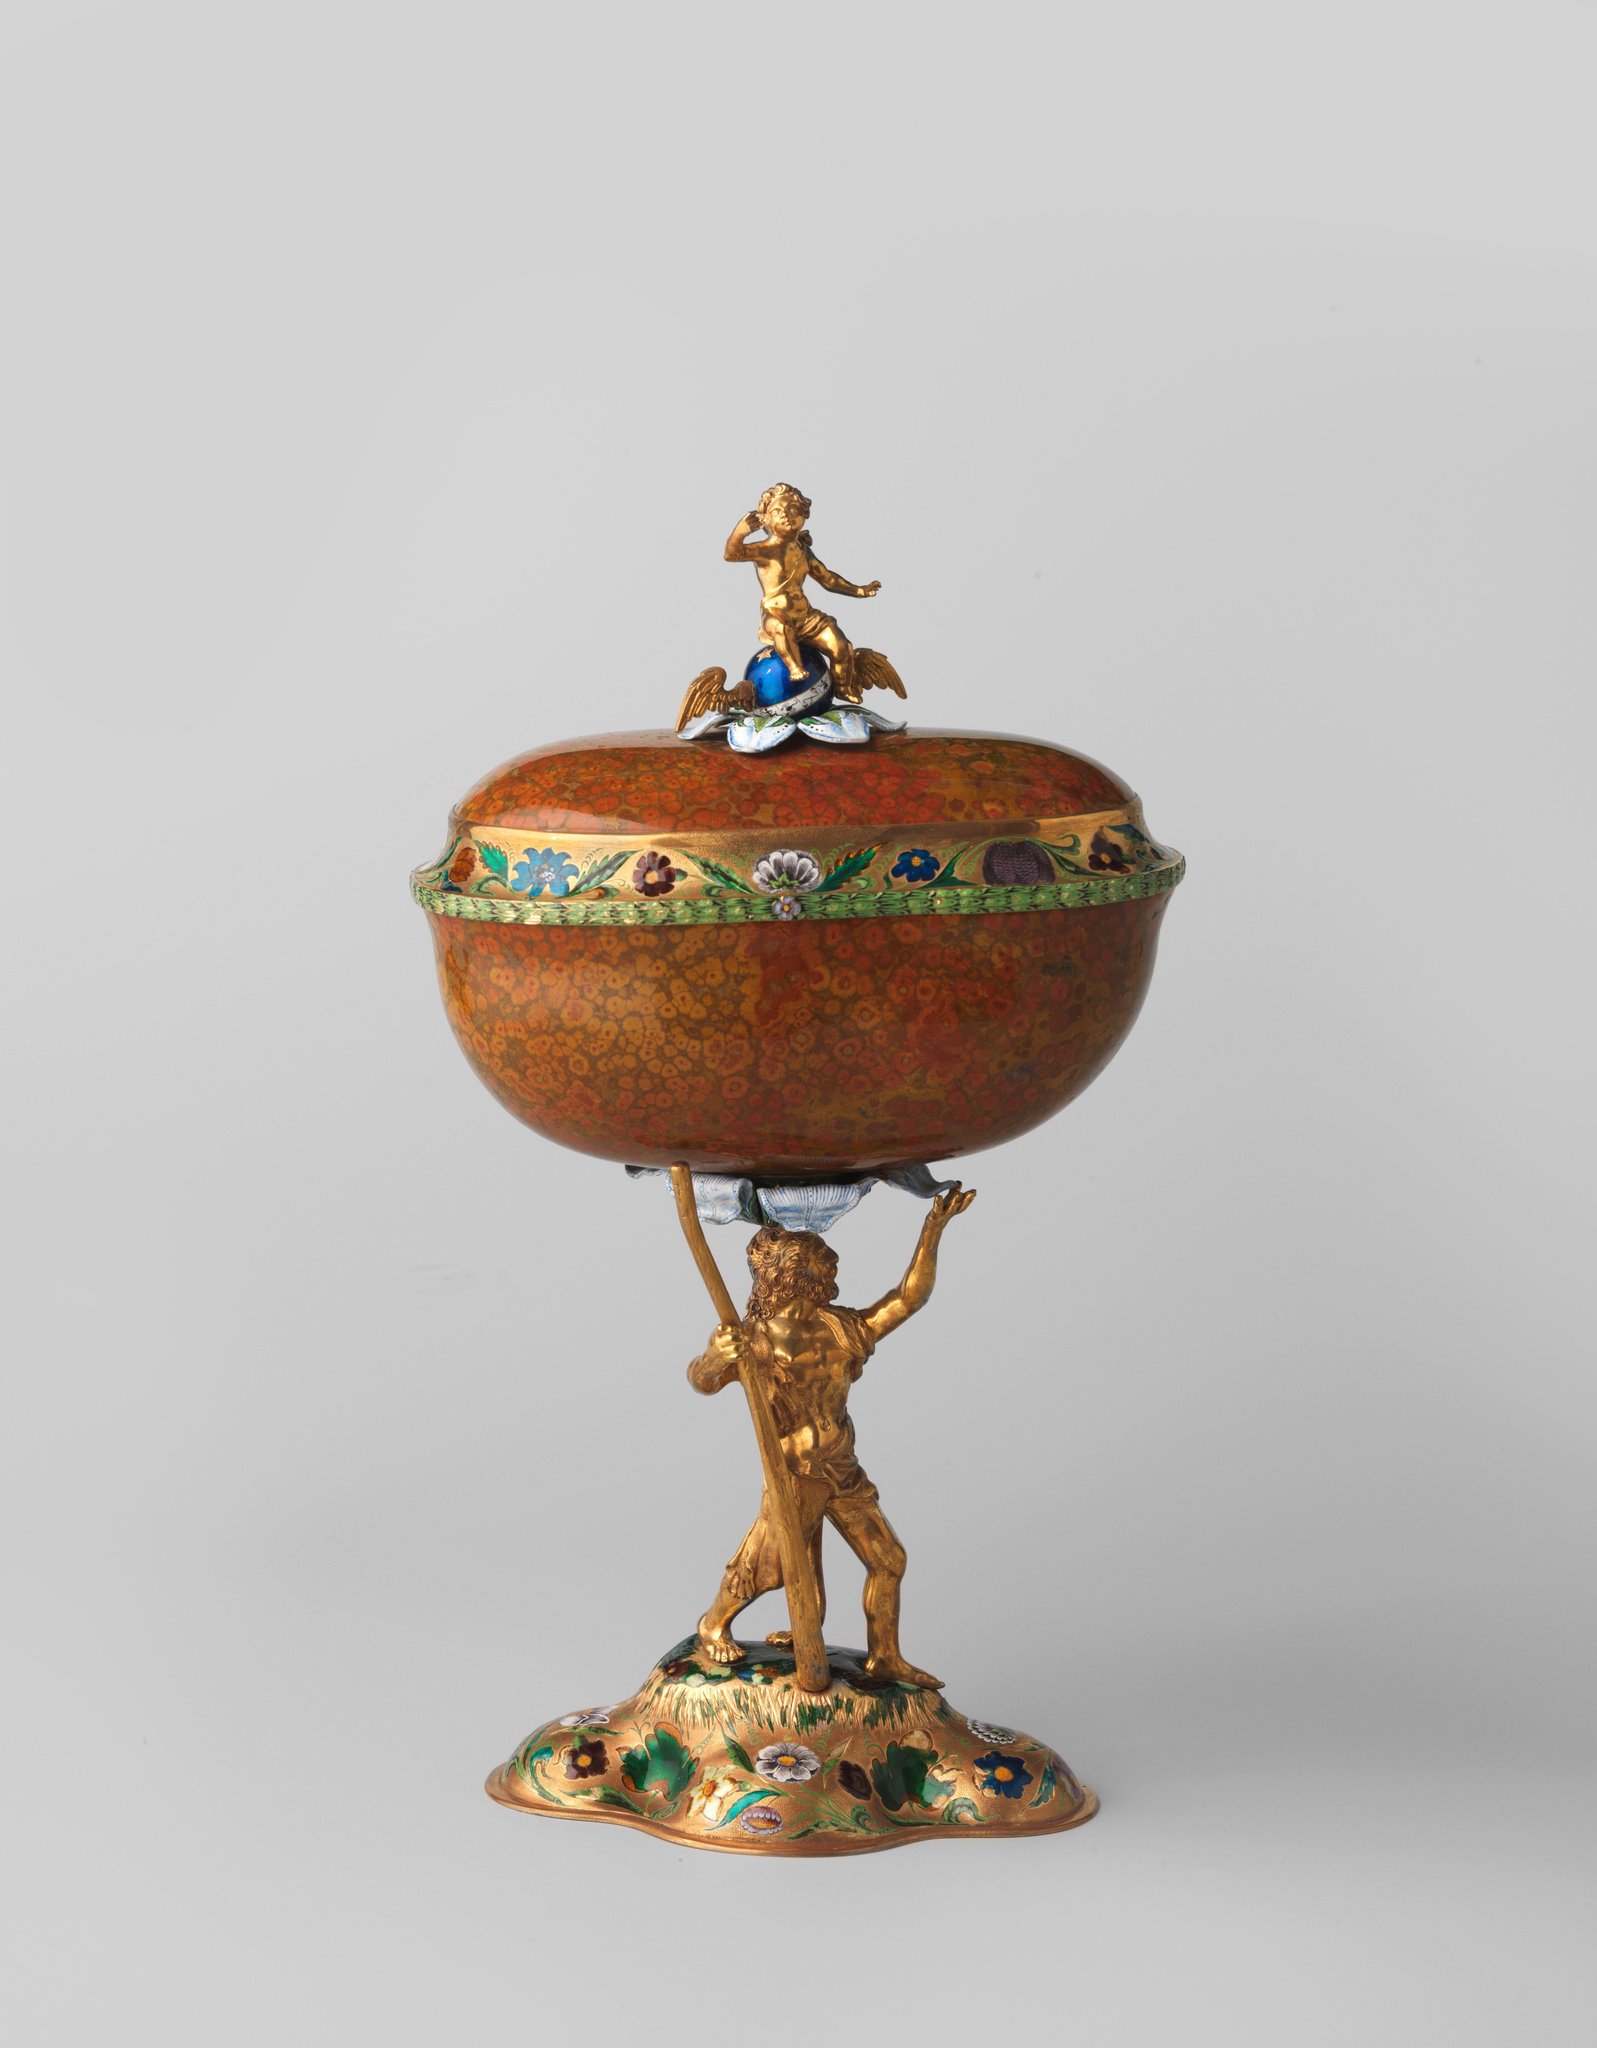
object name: coupe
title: Coupe van rood-bruin gevlekt chalcedoon met voet van goud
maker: Anonymous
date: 1640-1660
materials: stone, gold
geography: eastern europe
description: Deksel van rood-bruin gevlekt chalcedoon. Op de rand van het deksel veelkleurige bloemen in translucide email; en bovenop een geëmailleerde bloem in wit en blauw. Als bekroning een gouden putto op een bol van blauw email waaromheen Zodiac.